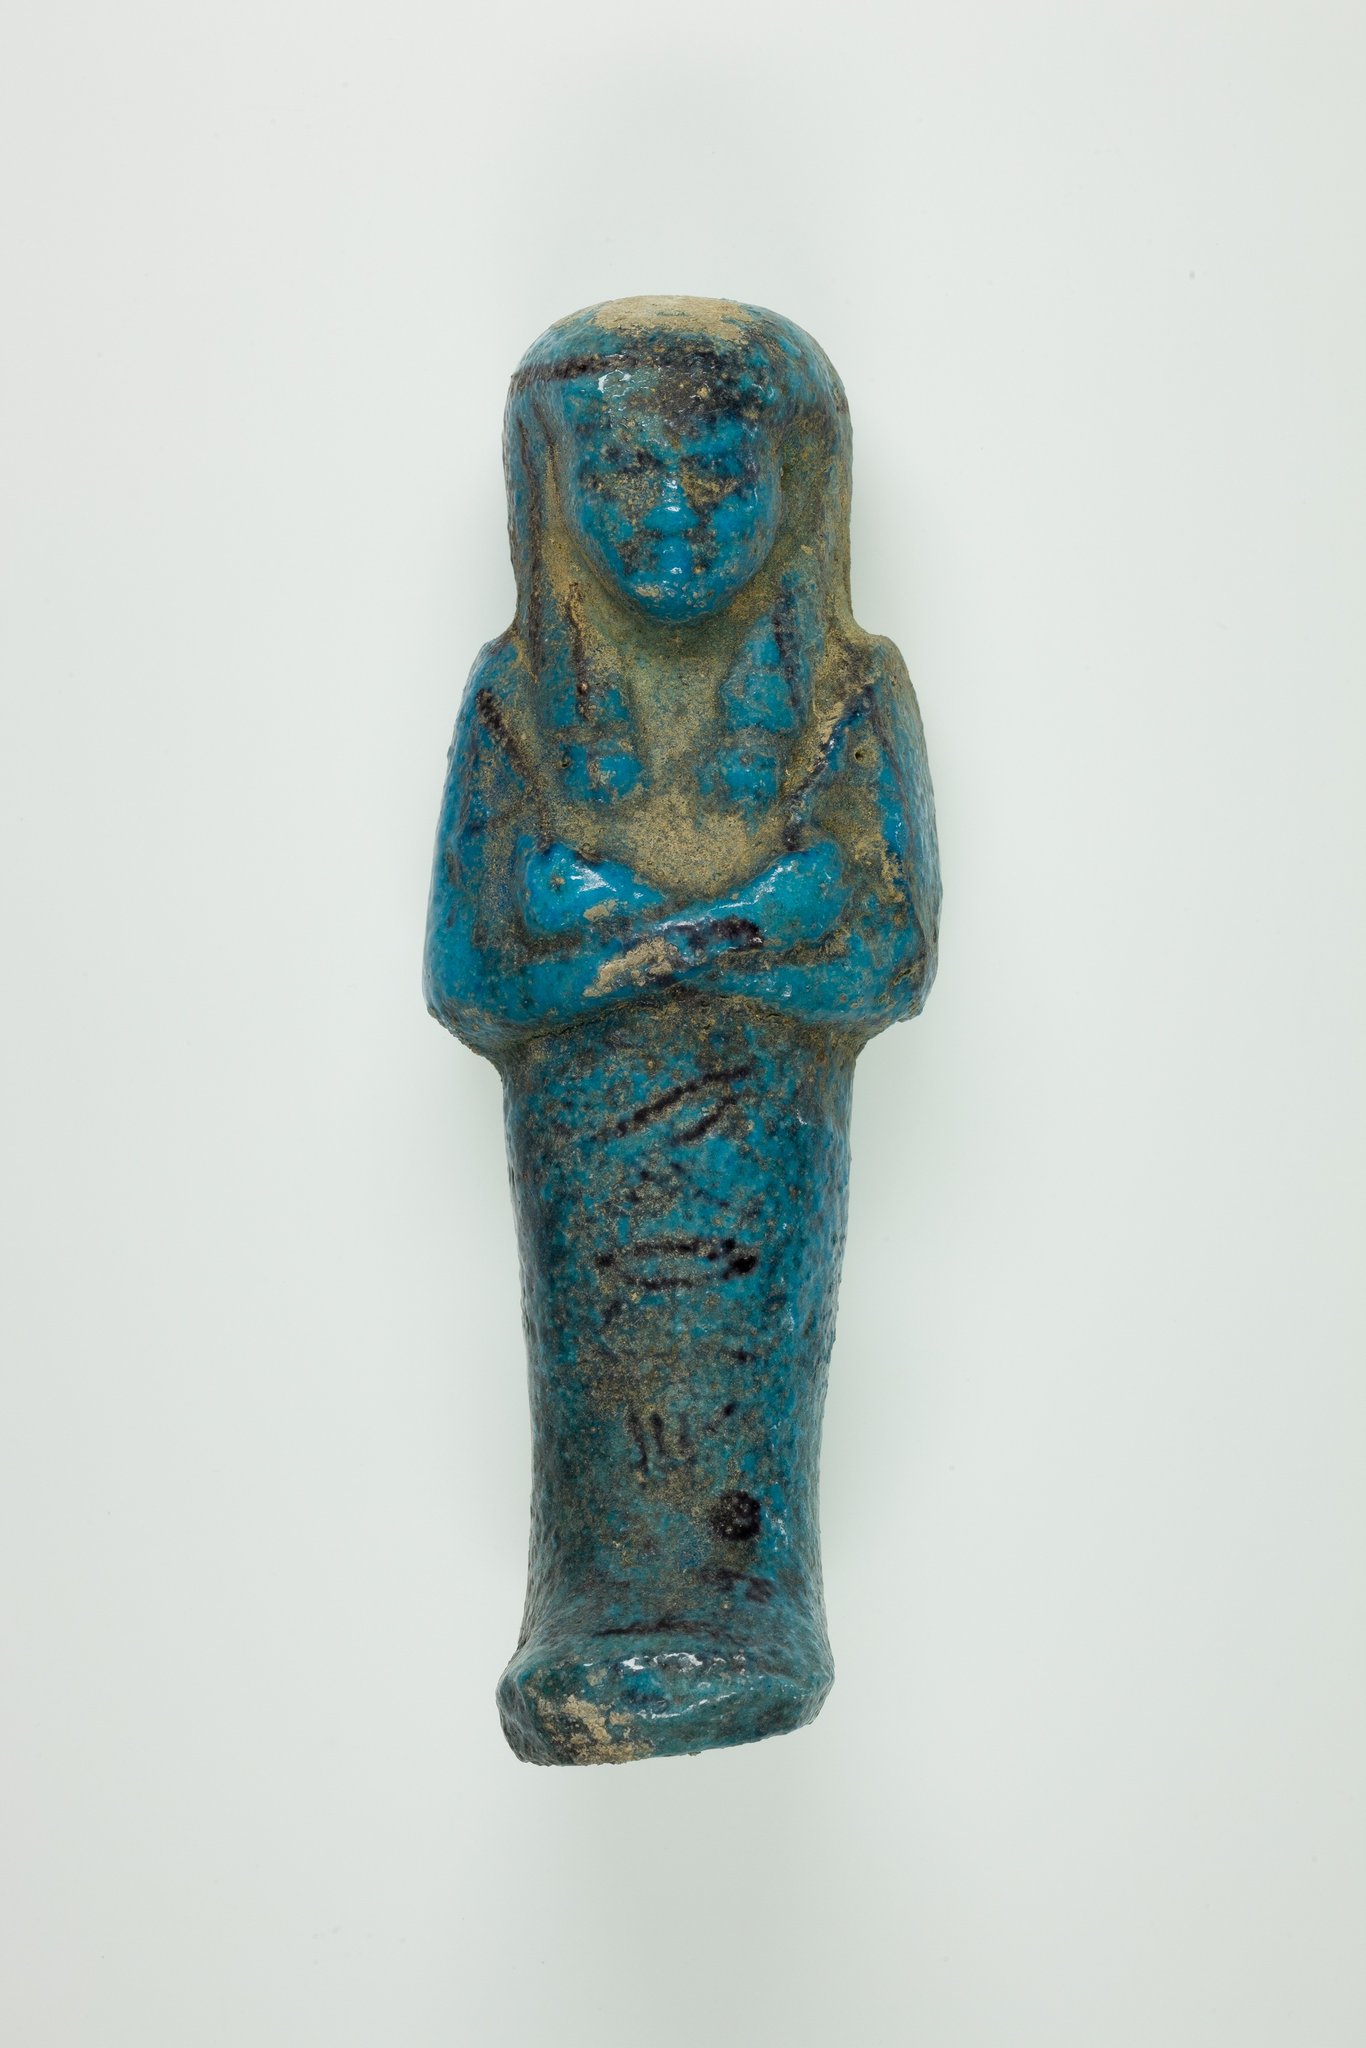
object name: worker shabti, henettawy c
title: Worker Shabti of Henettawy (C), Daughter of Isetemkheb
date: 990-970 BCE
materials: faience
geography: egypt